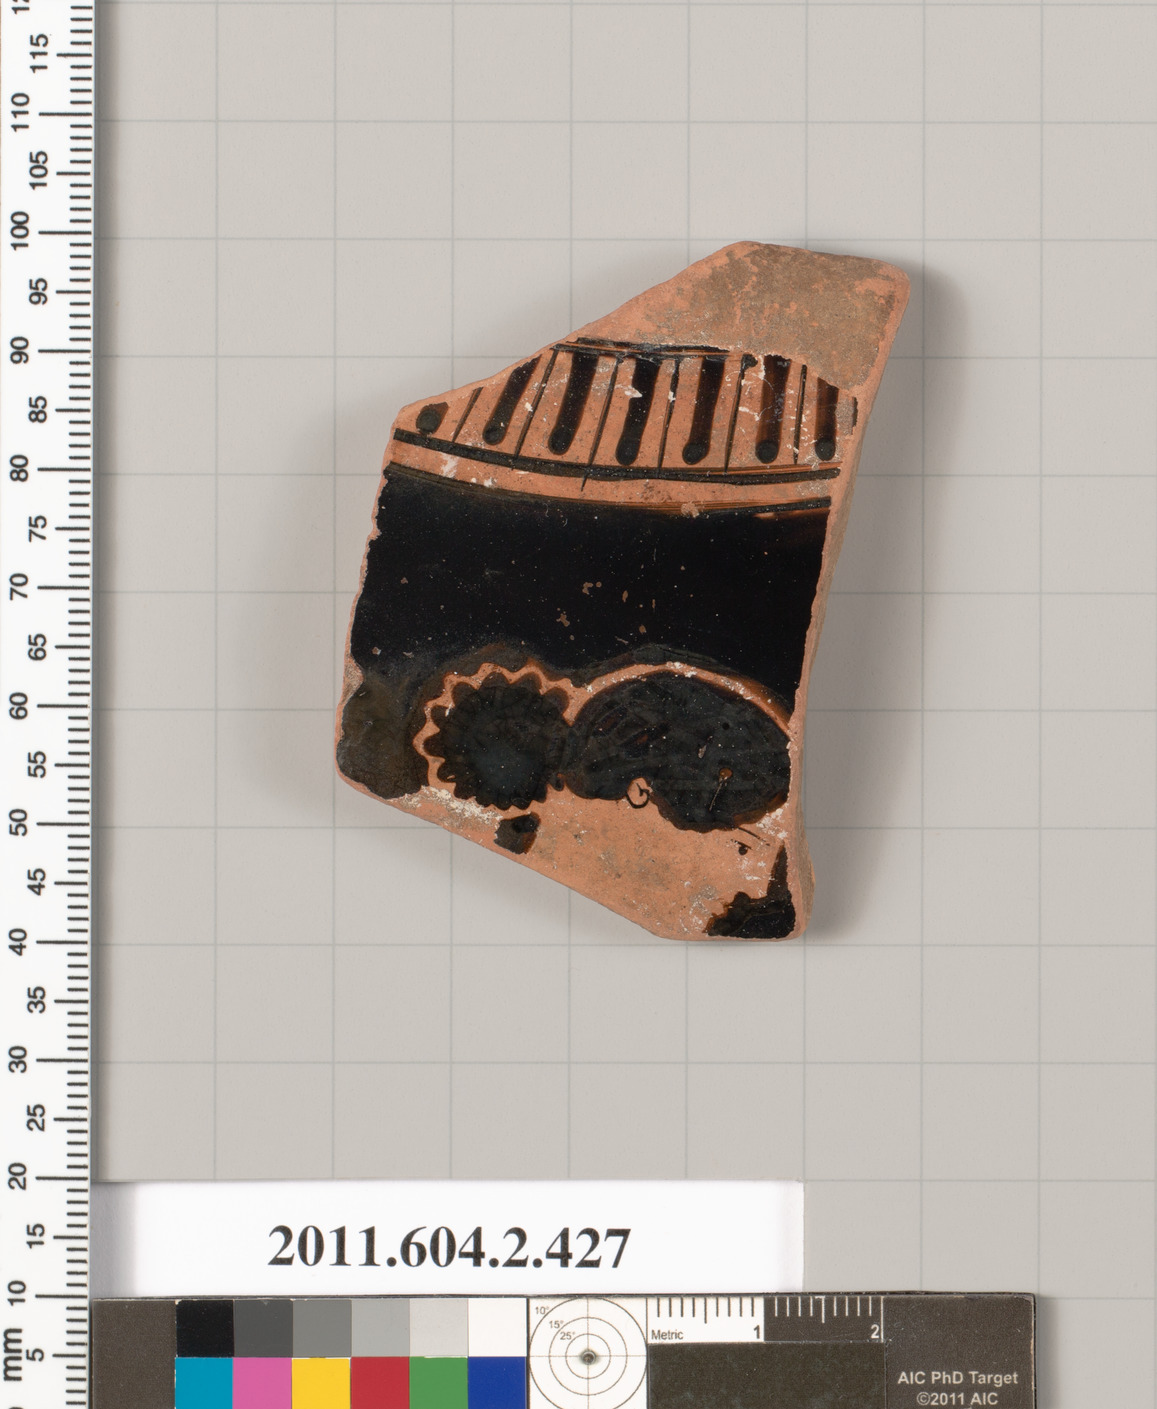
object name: column krater fragment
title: Terracotta fragment of a column-krater (bowl for mixing wine and water)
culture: greek, attic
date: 467-435 BCE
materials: terracotta